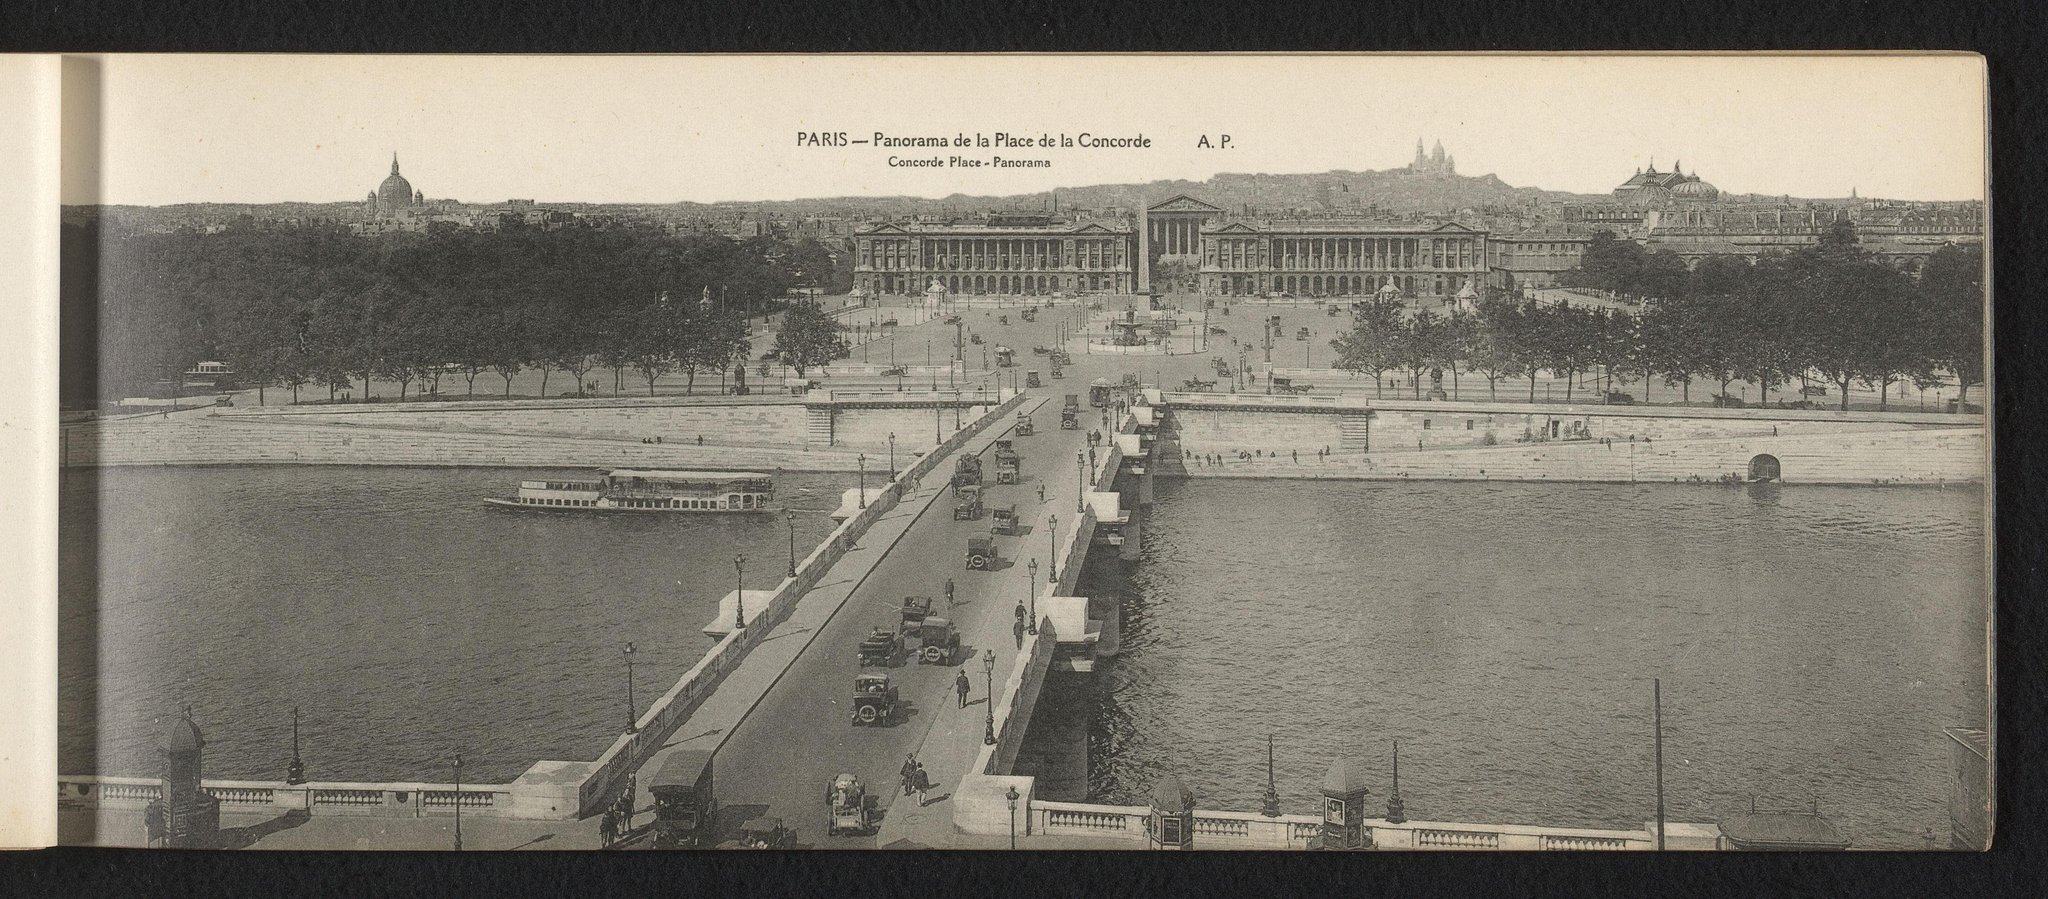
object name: photomechanical print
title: Paris. Panorama de la Place de la Concorde / Concorde Place. Panorama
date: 1910-1925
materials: cardboard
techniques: photograph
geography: paris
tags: bridge in city across river, canal, etc. (+ city(-scape) with figures, staffage), river, square, place, circus, etc. (+ city(-scape) with figures, staffage)